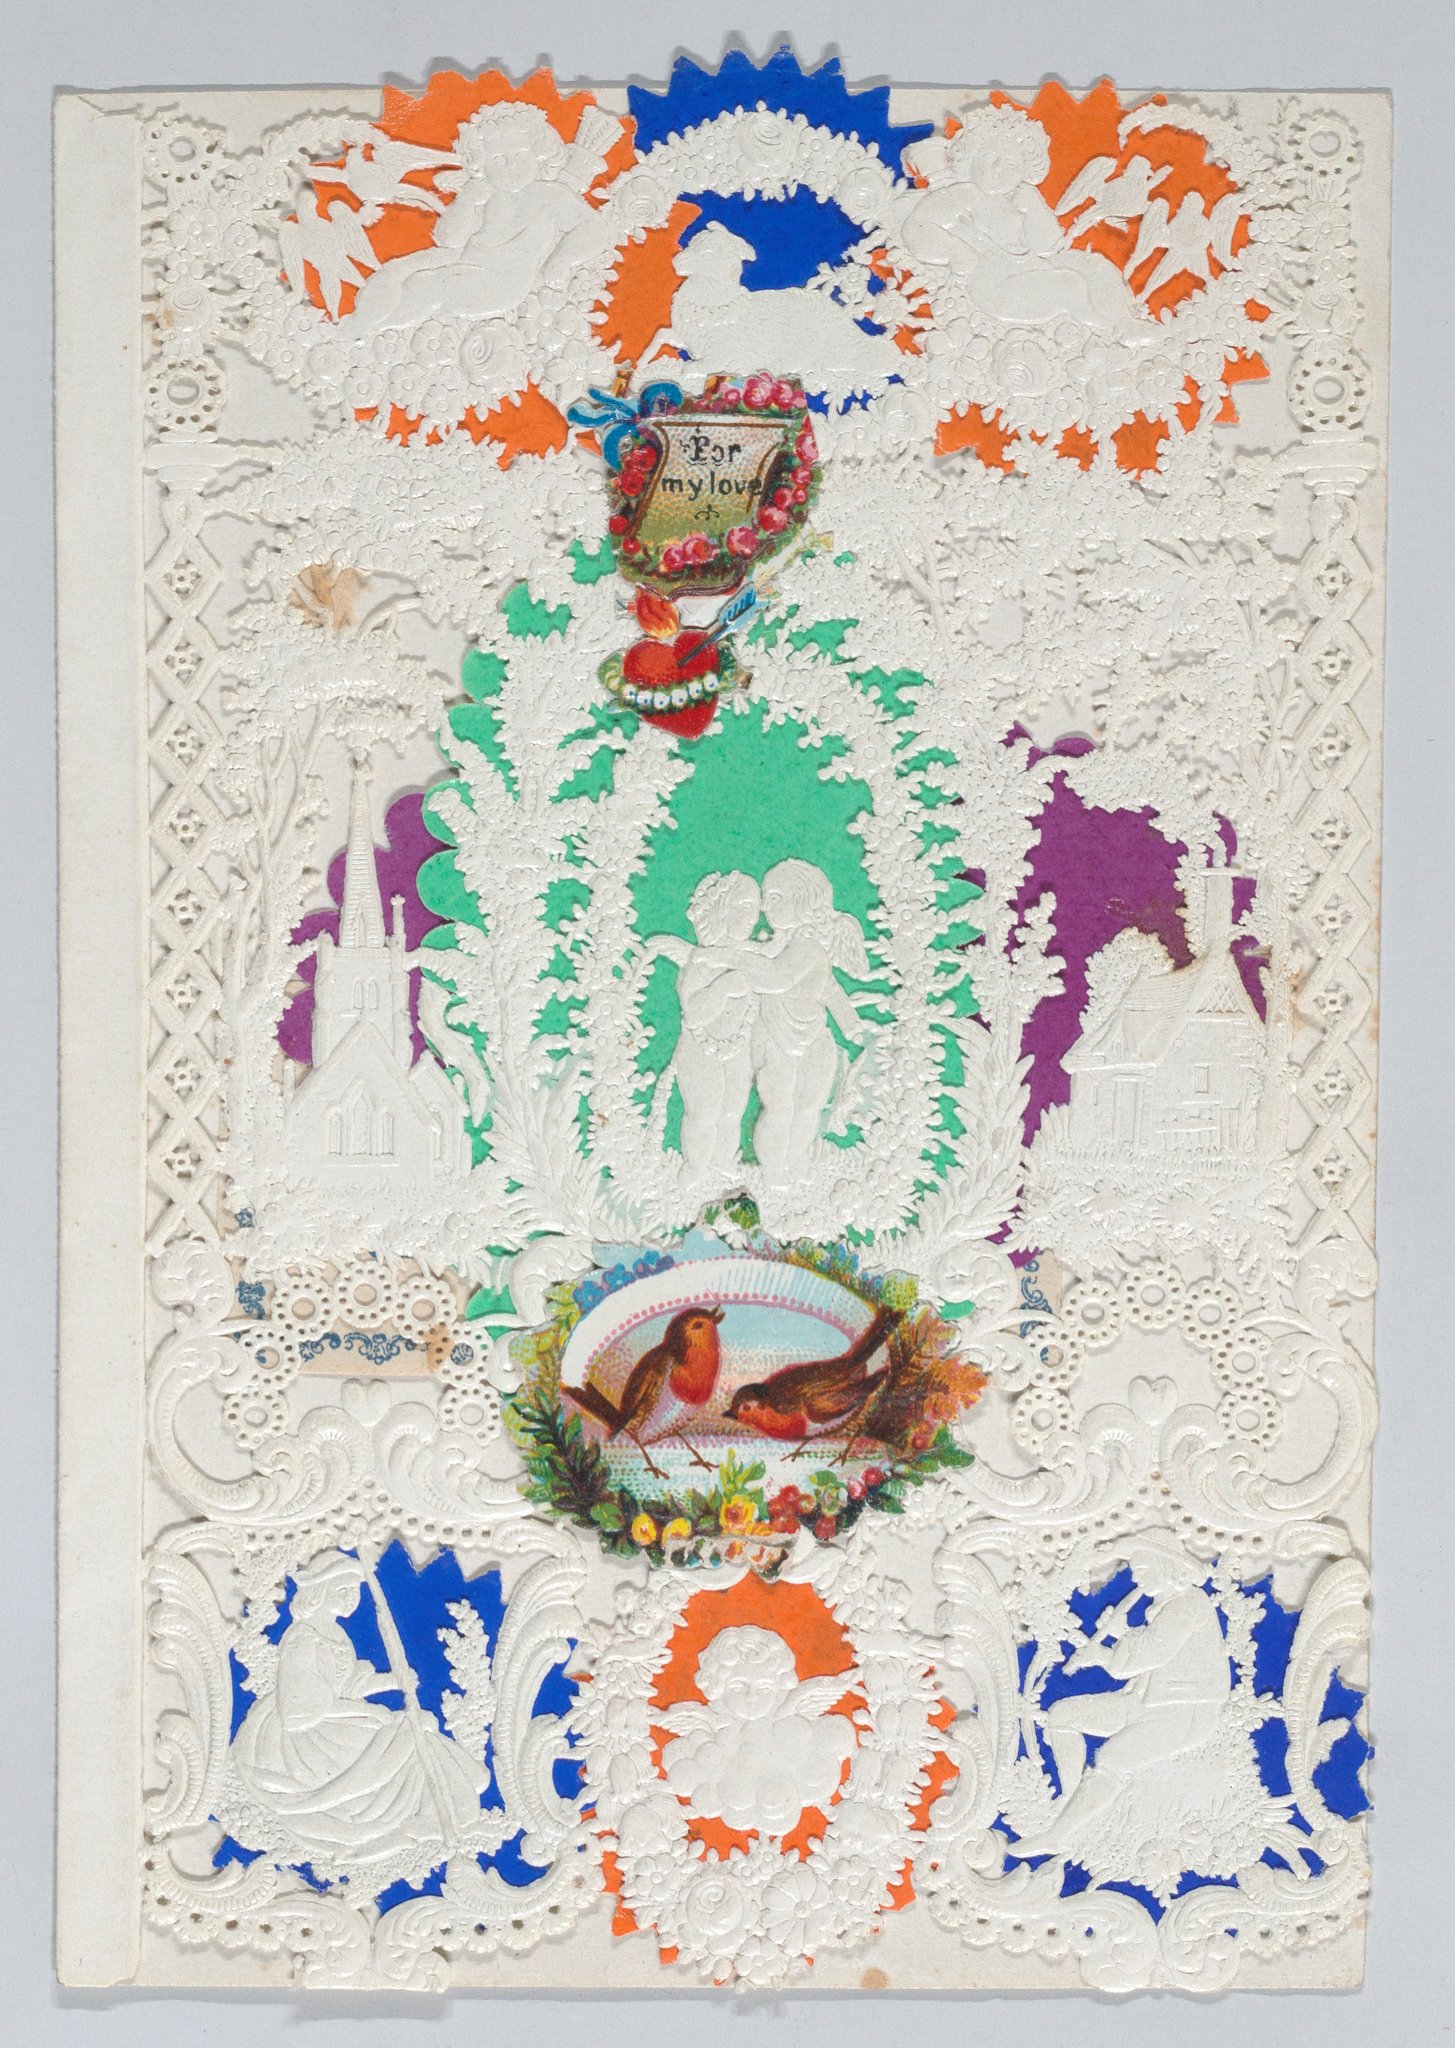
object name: valentine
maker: esther howland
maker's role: artist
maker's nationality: american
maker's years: 1828-1904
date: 1834-1866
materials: lace, paper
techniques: cutting, embossing, open work